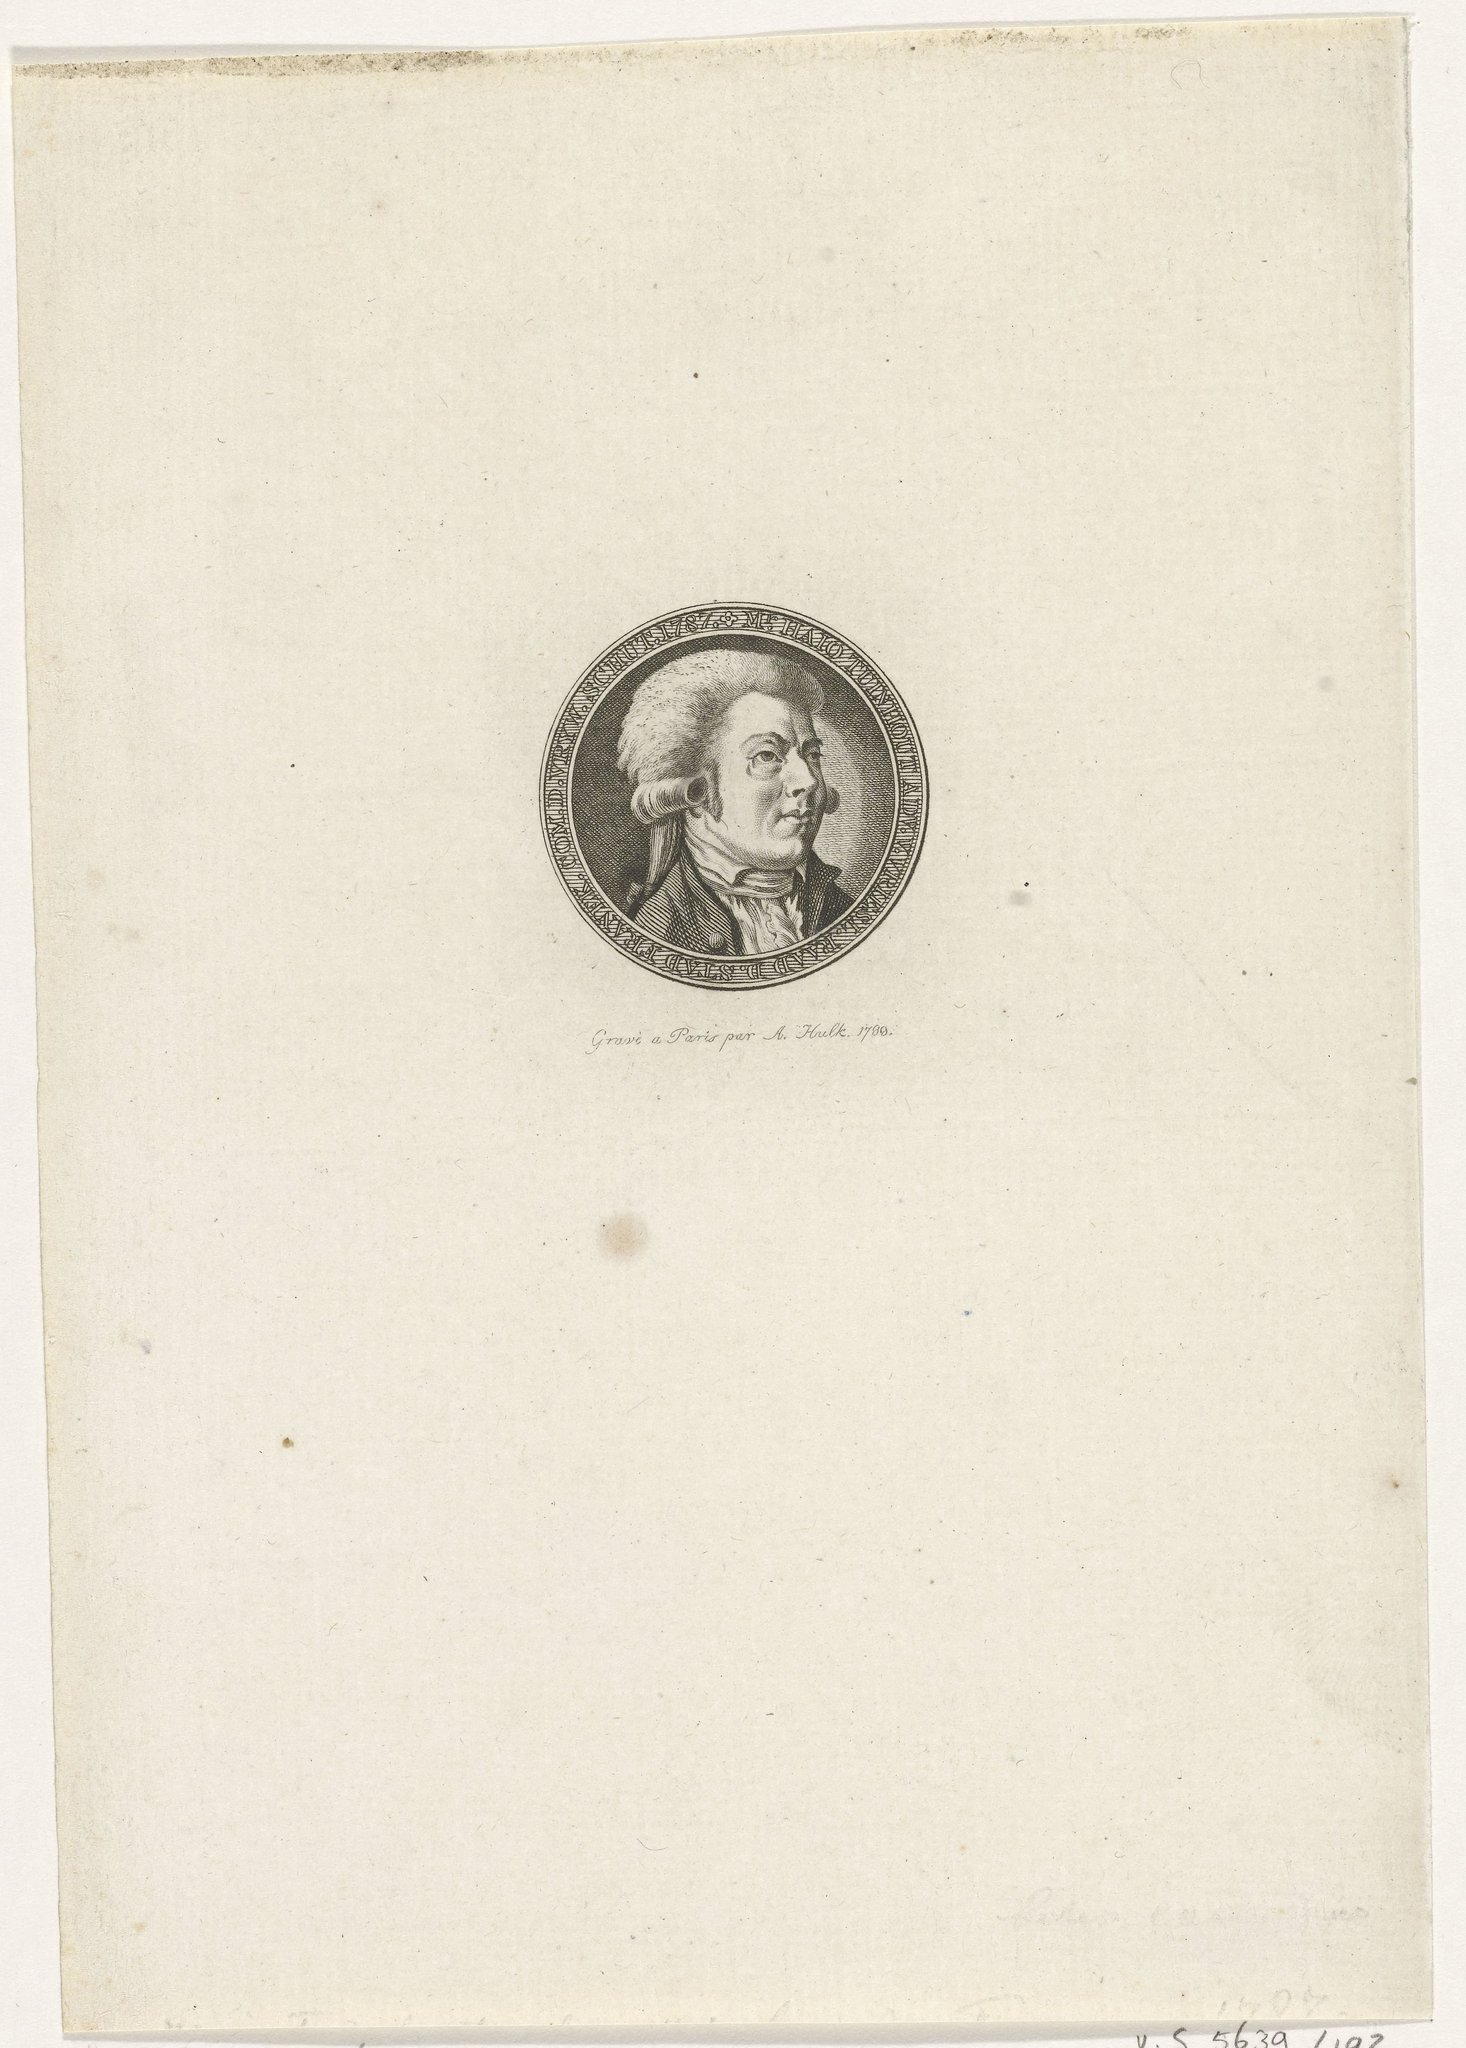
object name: print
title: Portretten van patriotten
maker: abraham jacobsz. hulk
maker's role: print maker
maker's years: 1751-1817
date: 1788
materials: paper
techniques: engraving, etching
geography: paris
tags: hayo tuinhout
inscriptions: collector's mark: Lugt 2228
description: Buste van Hayo Tuinhout naar rechts in een medaillon met randschrift in het Nederlands.